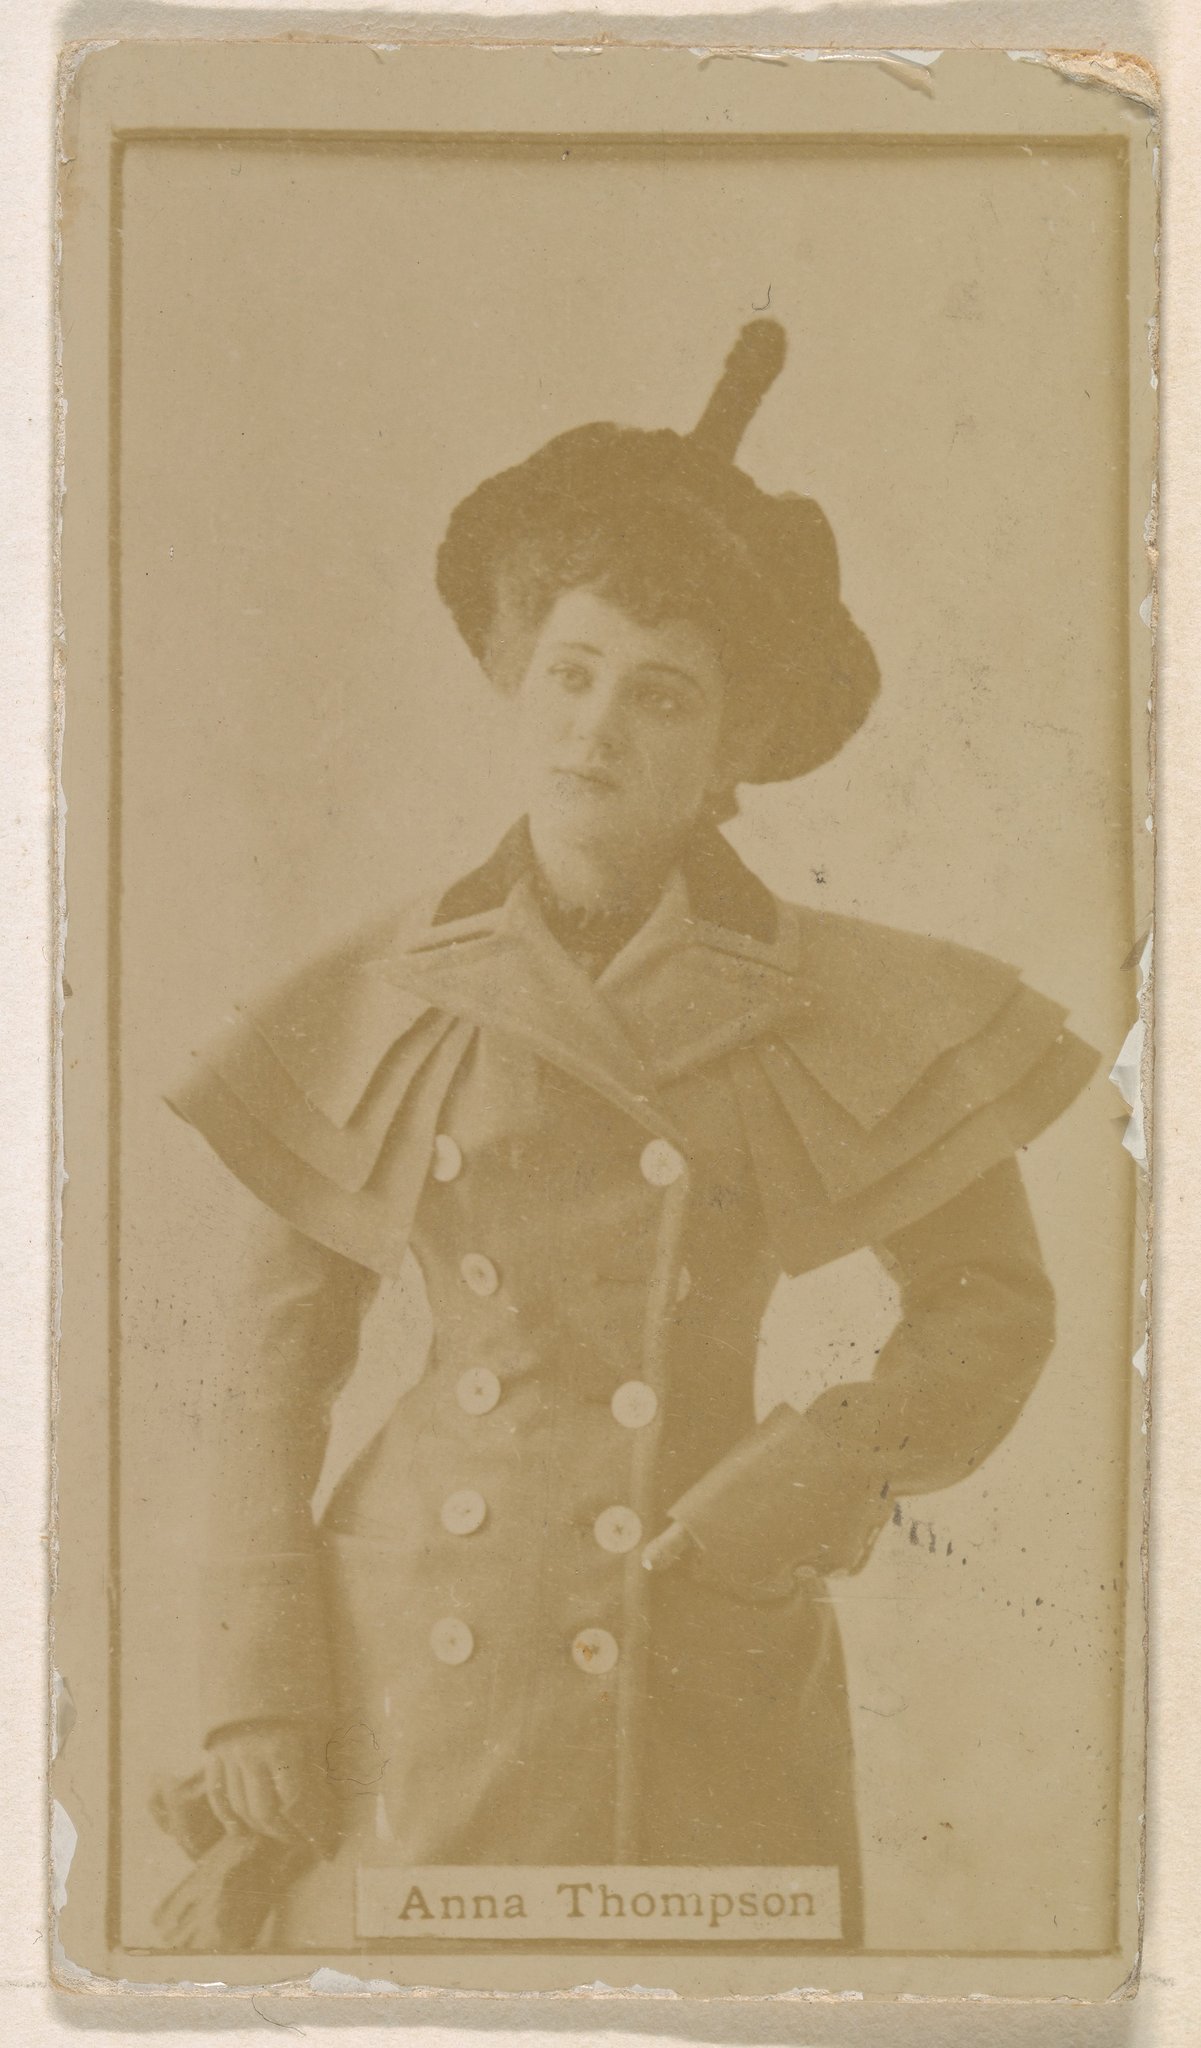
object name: photograph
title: Anna Thompson, from the Actresses series (N245) issued by Kinney Brothers to promote Sweet Caporal Cigarettes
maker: kinney brothers tobacco company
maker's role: publisher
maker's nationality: american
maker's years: 1869-2011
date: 1890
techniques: albumen silver print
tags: portraits,women,actresses